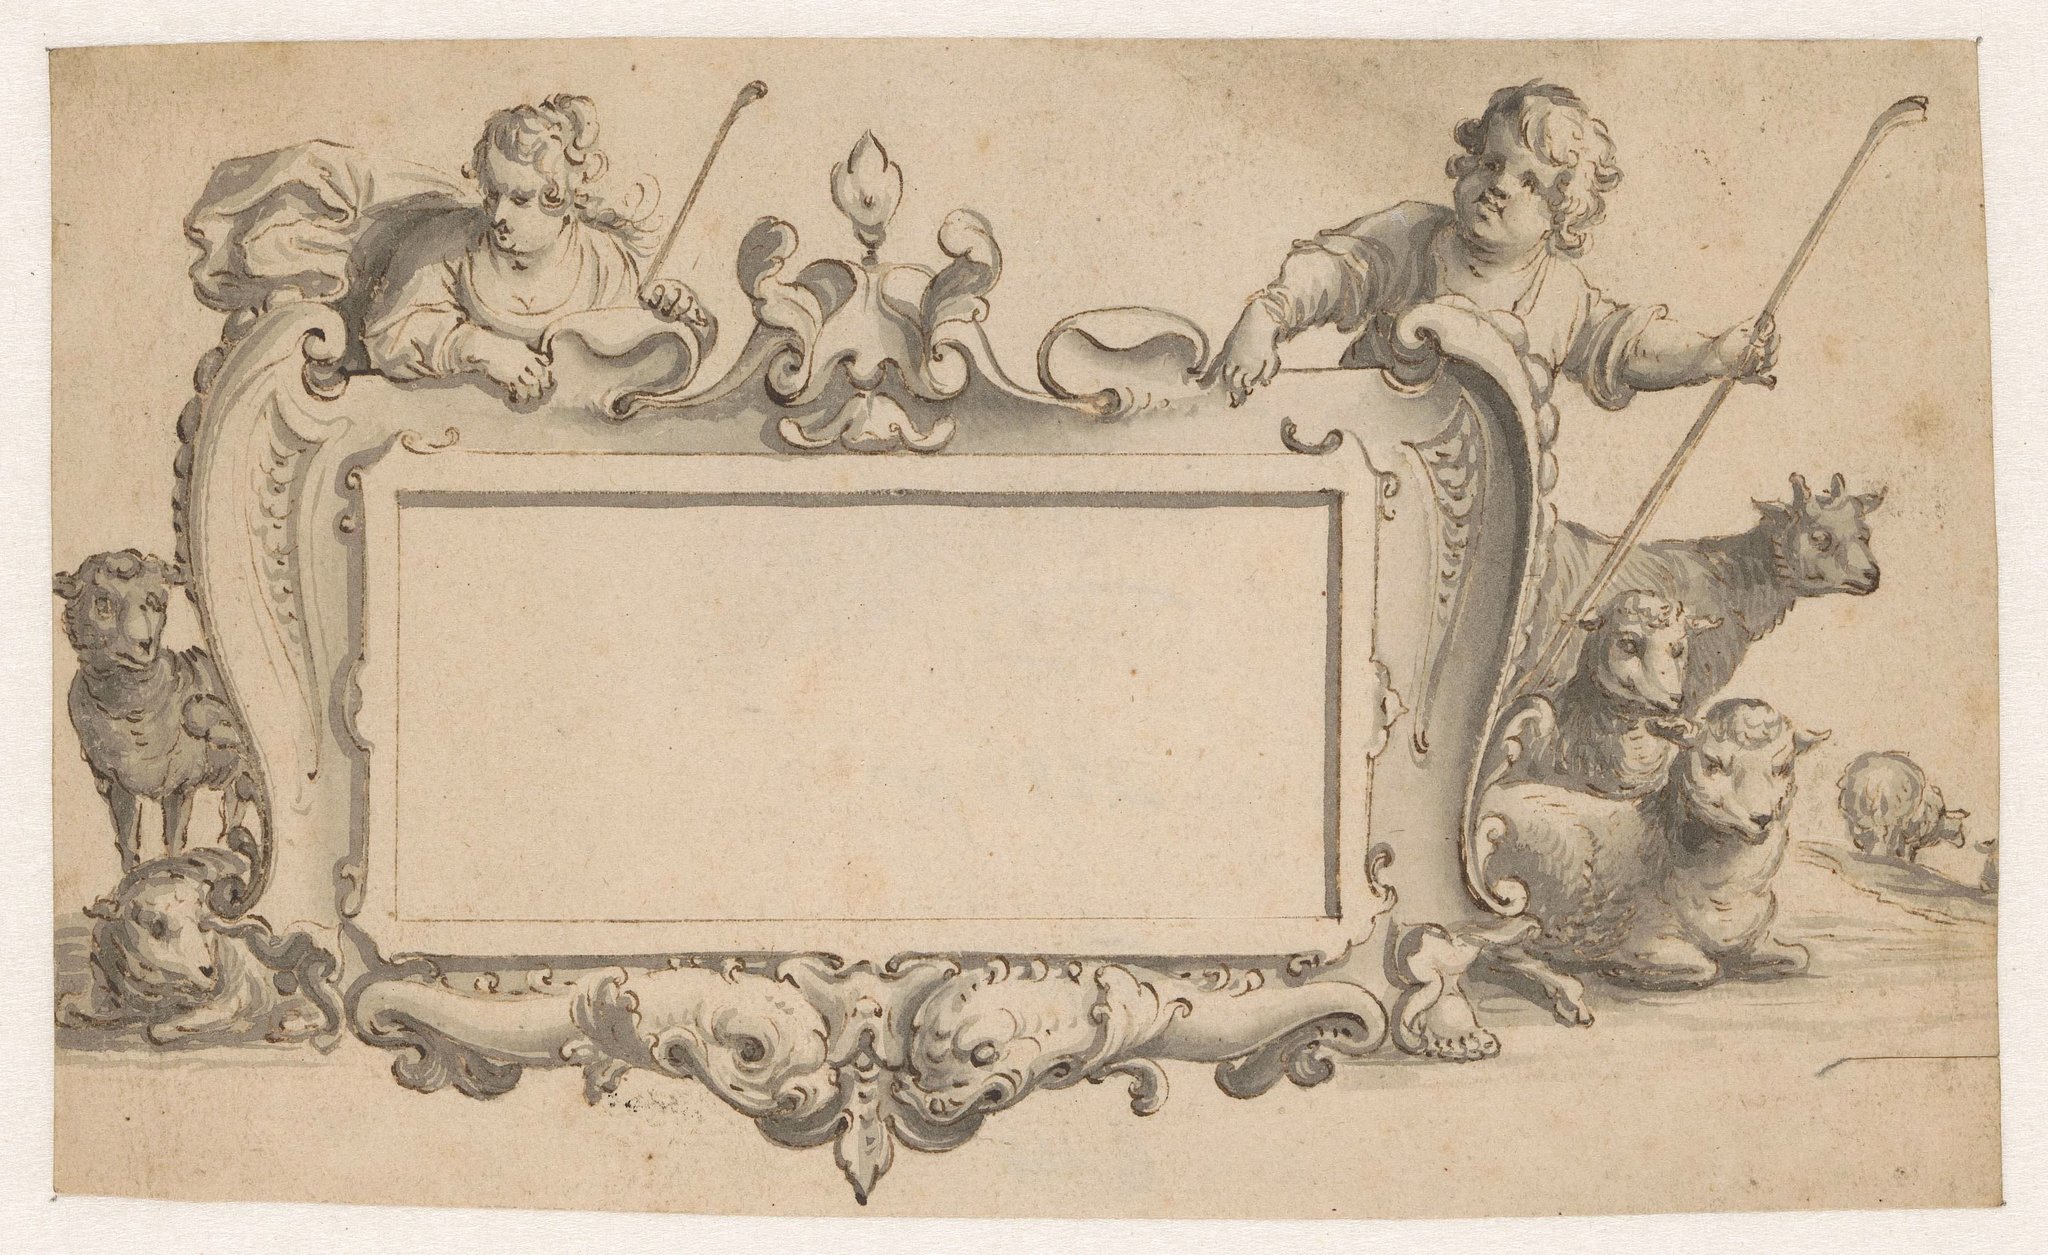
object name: drawing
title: Rechthoekige cartouche met herder, herderin en schapen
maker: pieter jansz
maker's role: draughtsman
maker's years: 1602-1672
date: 1612-1672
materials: ink, paper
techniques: brush, pen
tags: fishes, bread, loaf, ornament ~ cartouche, fish; still life of fishes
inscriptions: collector's mark: Lugt 2228